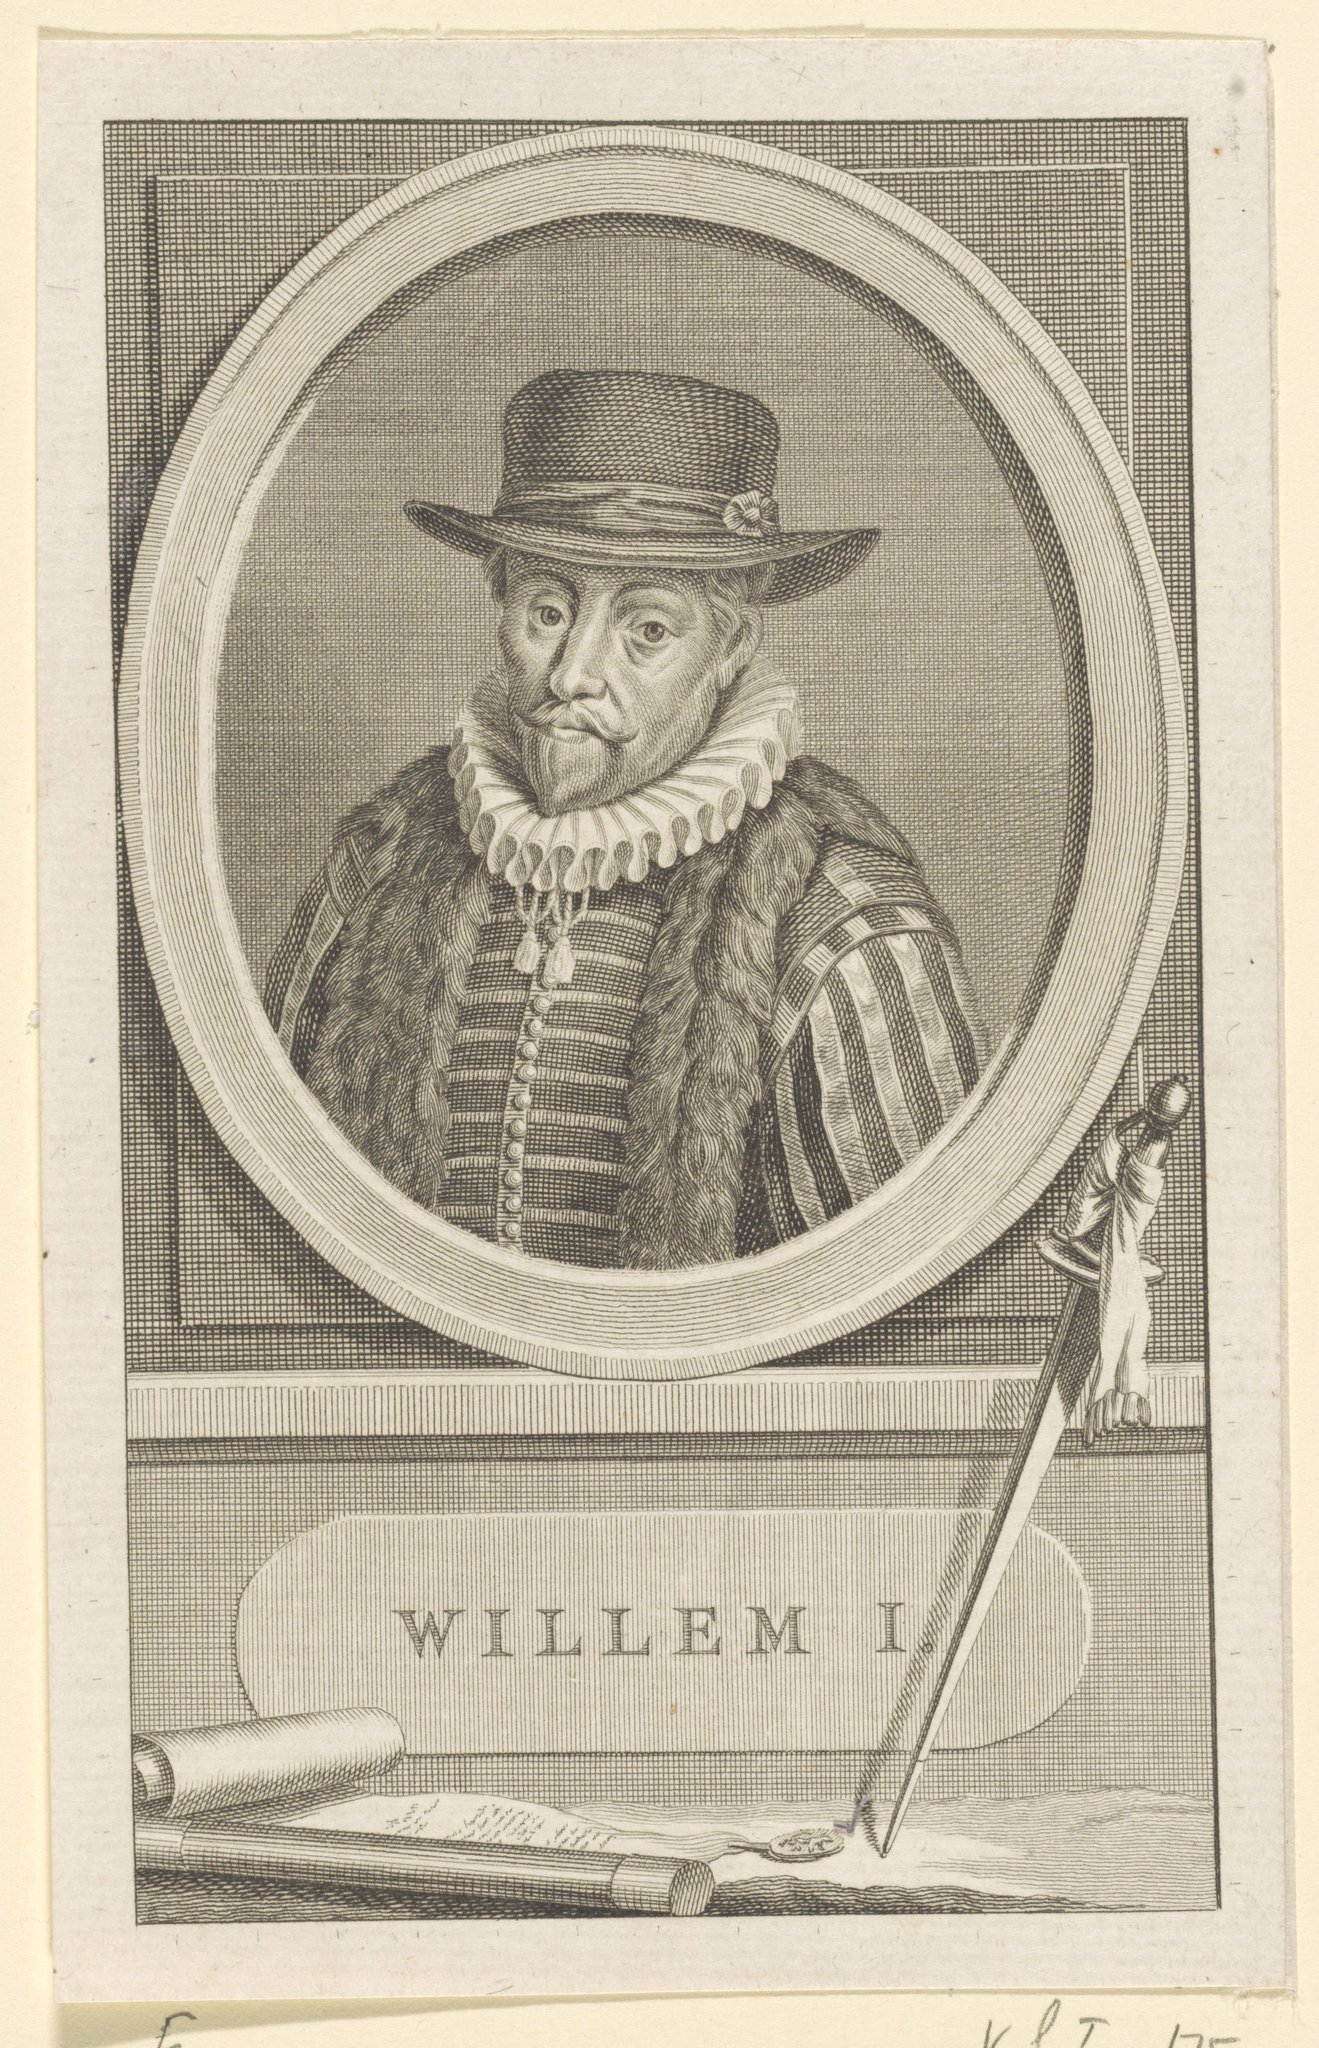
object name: print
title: Portret van Willem I, prins van Oranje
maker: Anonymous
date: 1787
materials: paper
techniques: engraving, etching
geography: low countries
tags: delft, william i (prince of orange)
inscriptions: collector's mark: Lugt 963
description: De hier vermelde titel verwijst naar de hoogst verkregen titel van de geportretteerde, niet per se naar de titel die de geportretteerde op deze voorstelling draagt.